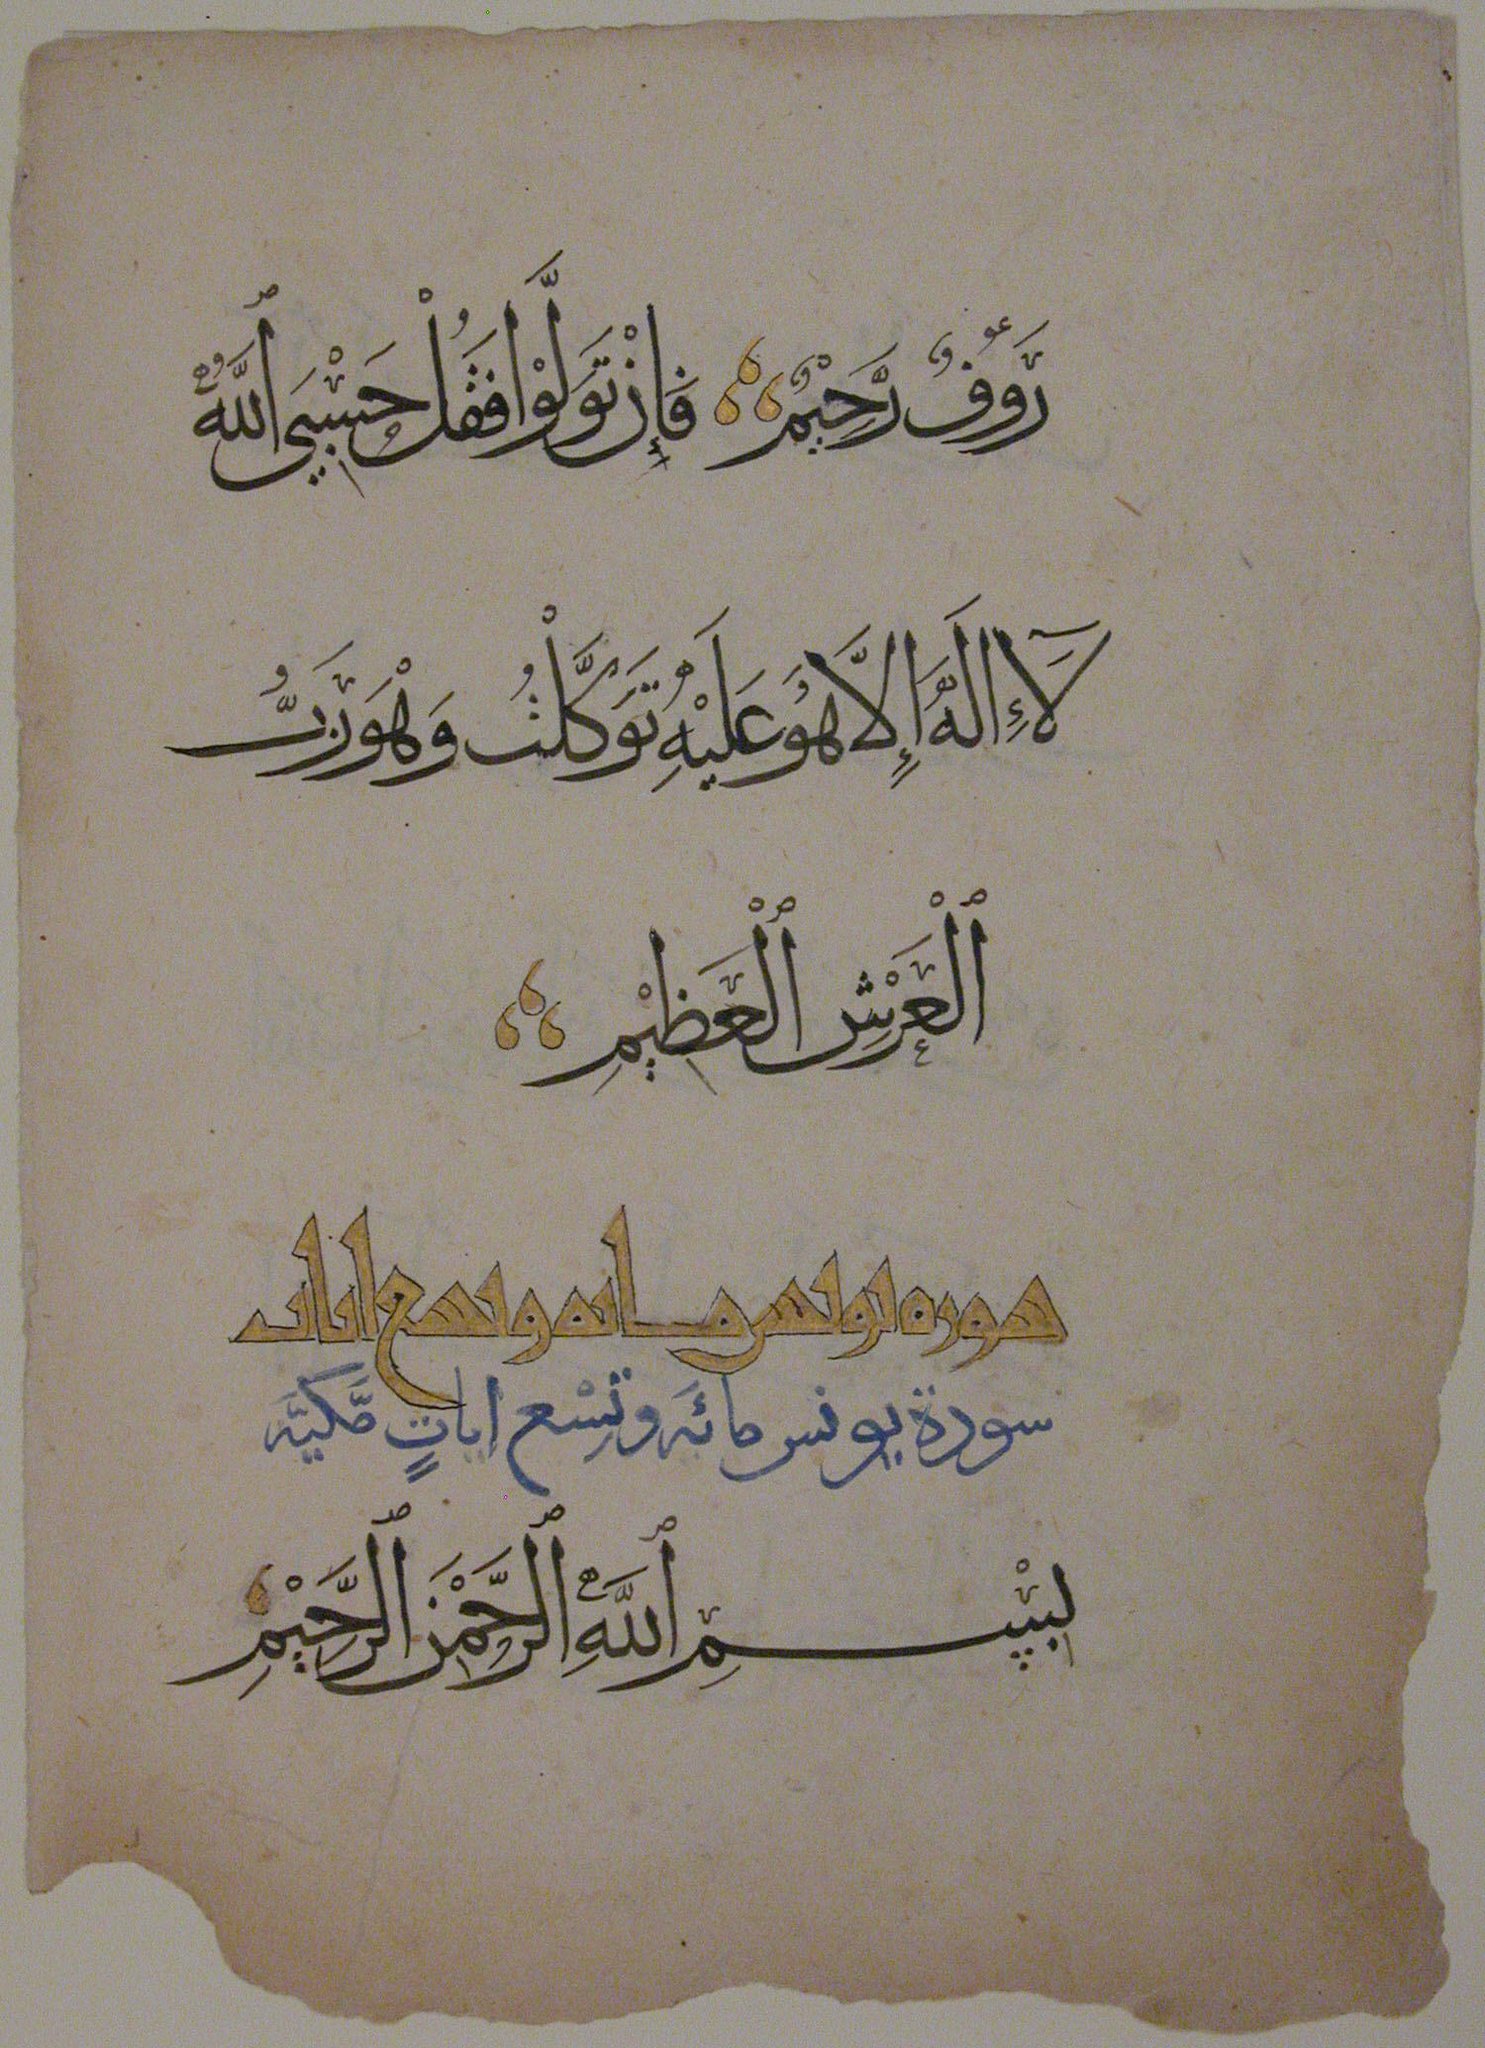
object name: folio from a non illustrated manuscript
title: Folio from a Qur'an Manuscript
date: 1401-1500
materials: gold, ink, paper, watercolor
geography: egypt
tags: qur'an,calligraphy